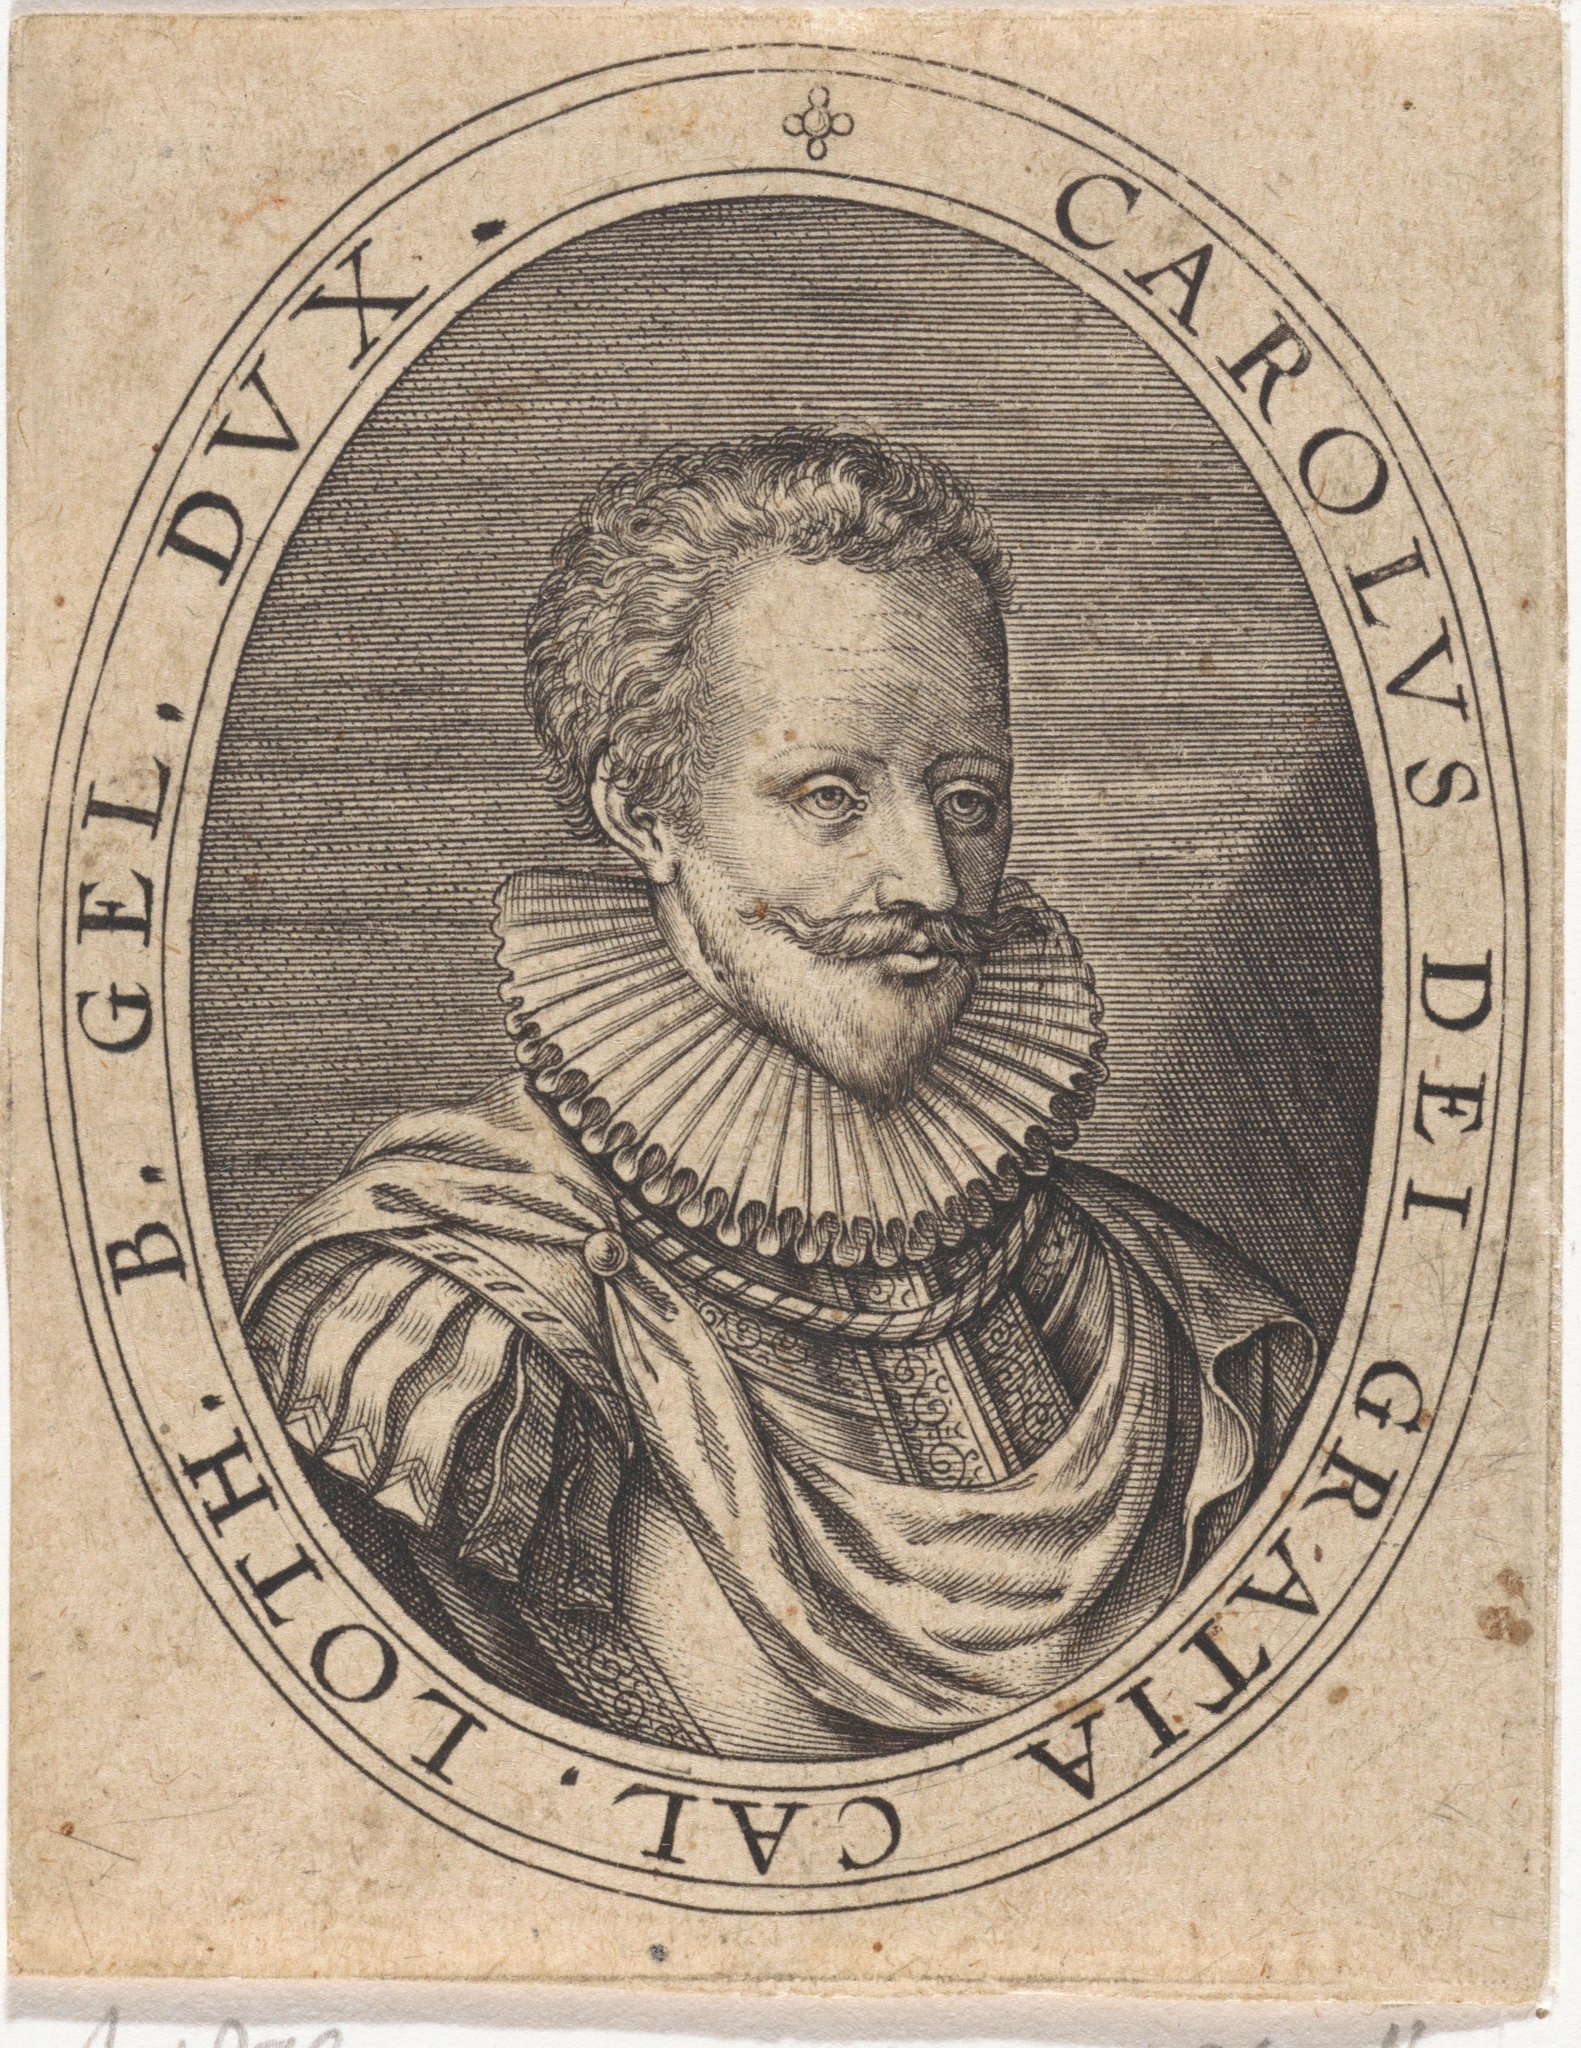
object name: print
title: Portret van Karel III, hertog van Lotharingen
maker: Anonymous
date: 1550-1600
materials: paper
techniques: engraving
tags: nancy, hertog, karel iii (hertog van lotharingen)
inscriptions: collector's mark: Lugt 240